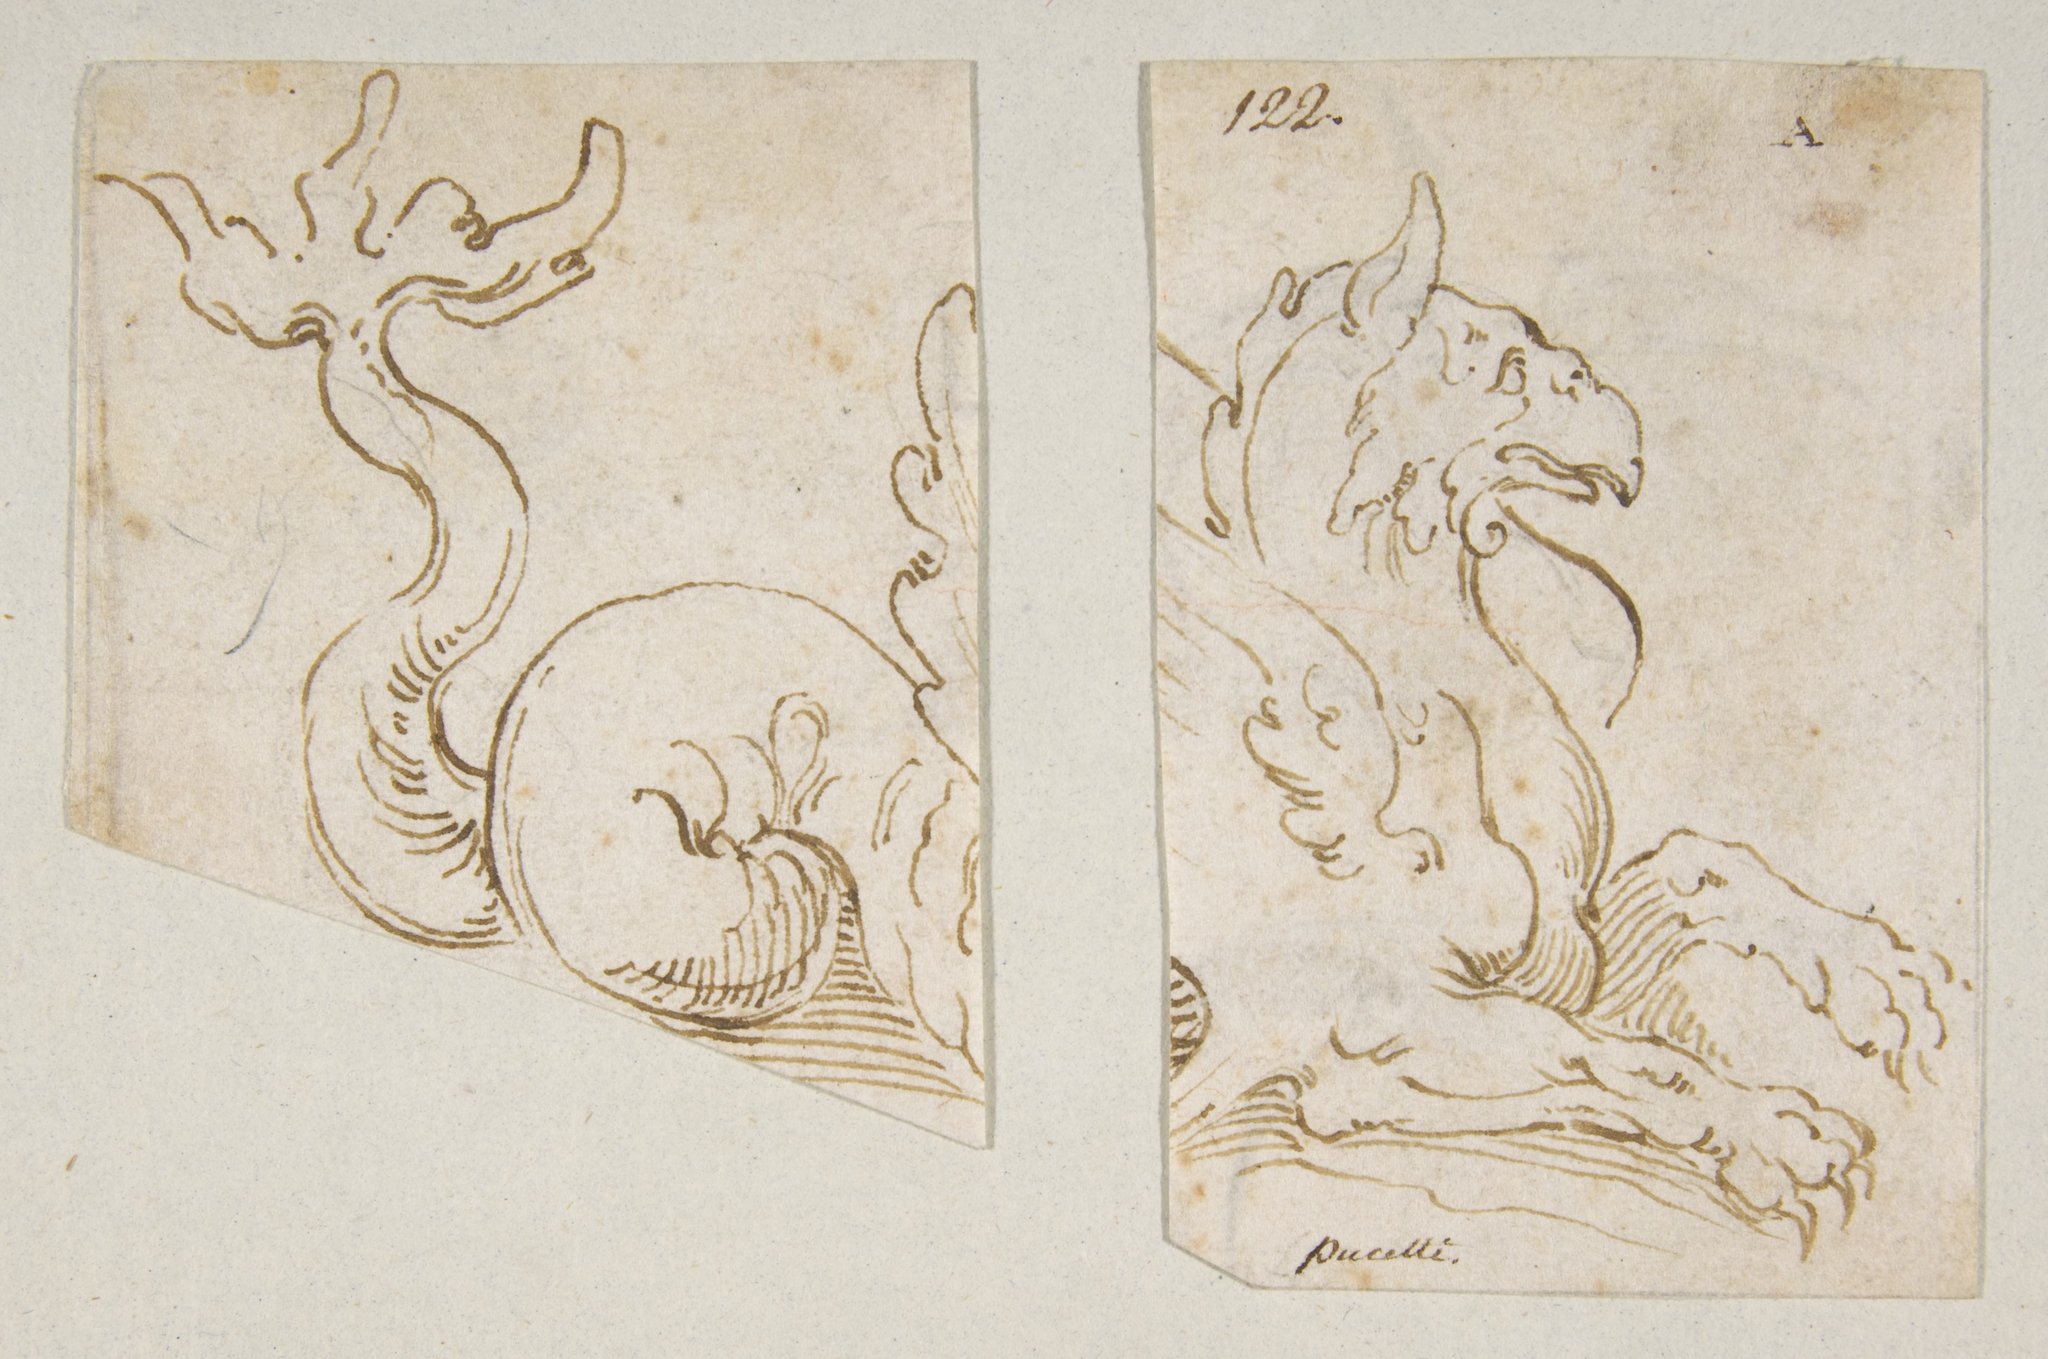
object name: drawing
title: Sea Monster (in two fragments)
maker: bernardino poccetti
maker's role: artist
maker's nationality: italian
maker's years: 1548-1612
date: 1548-1612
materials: ink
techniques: pen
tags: monsters